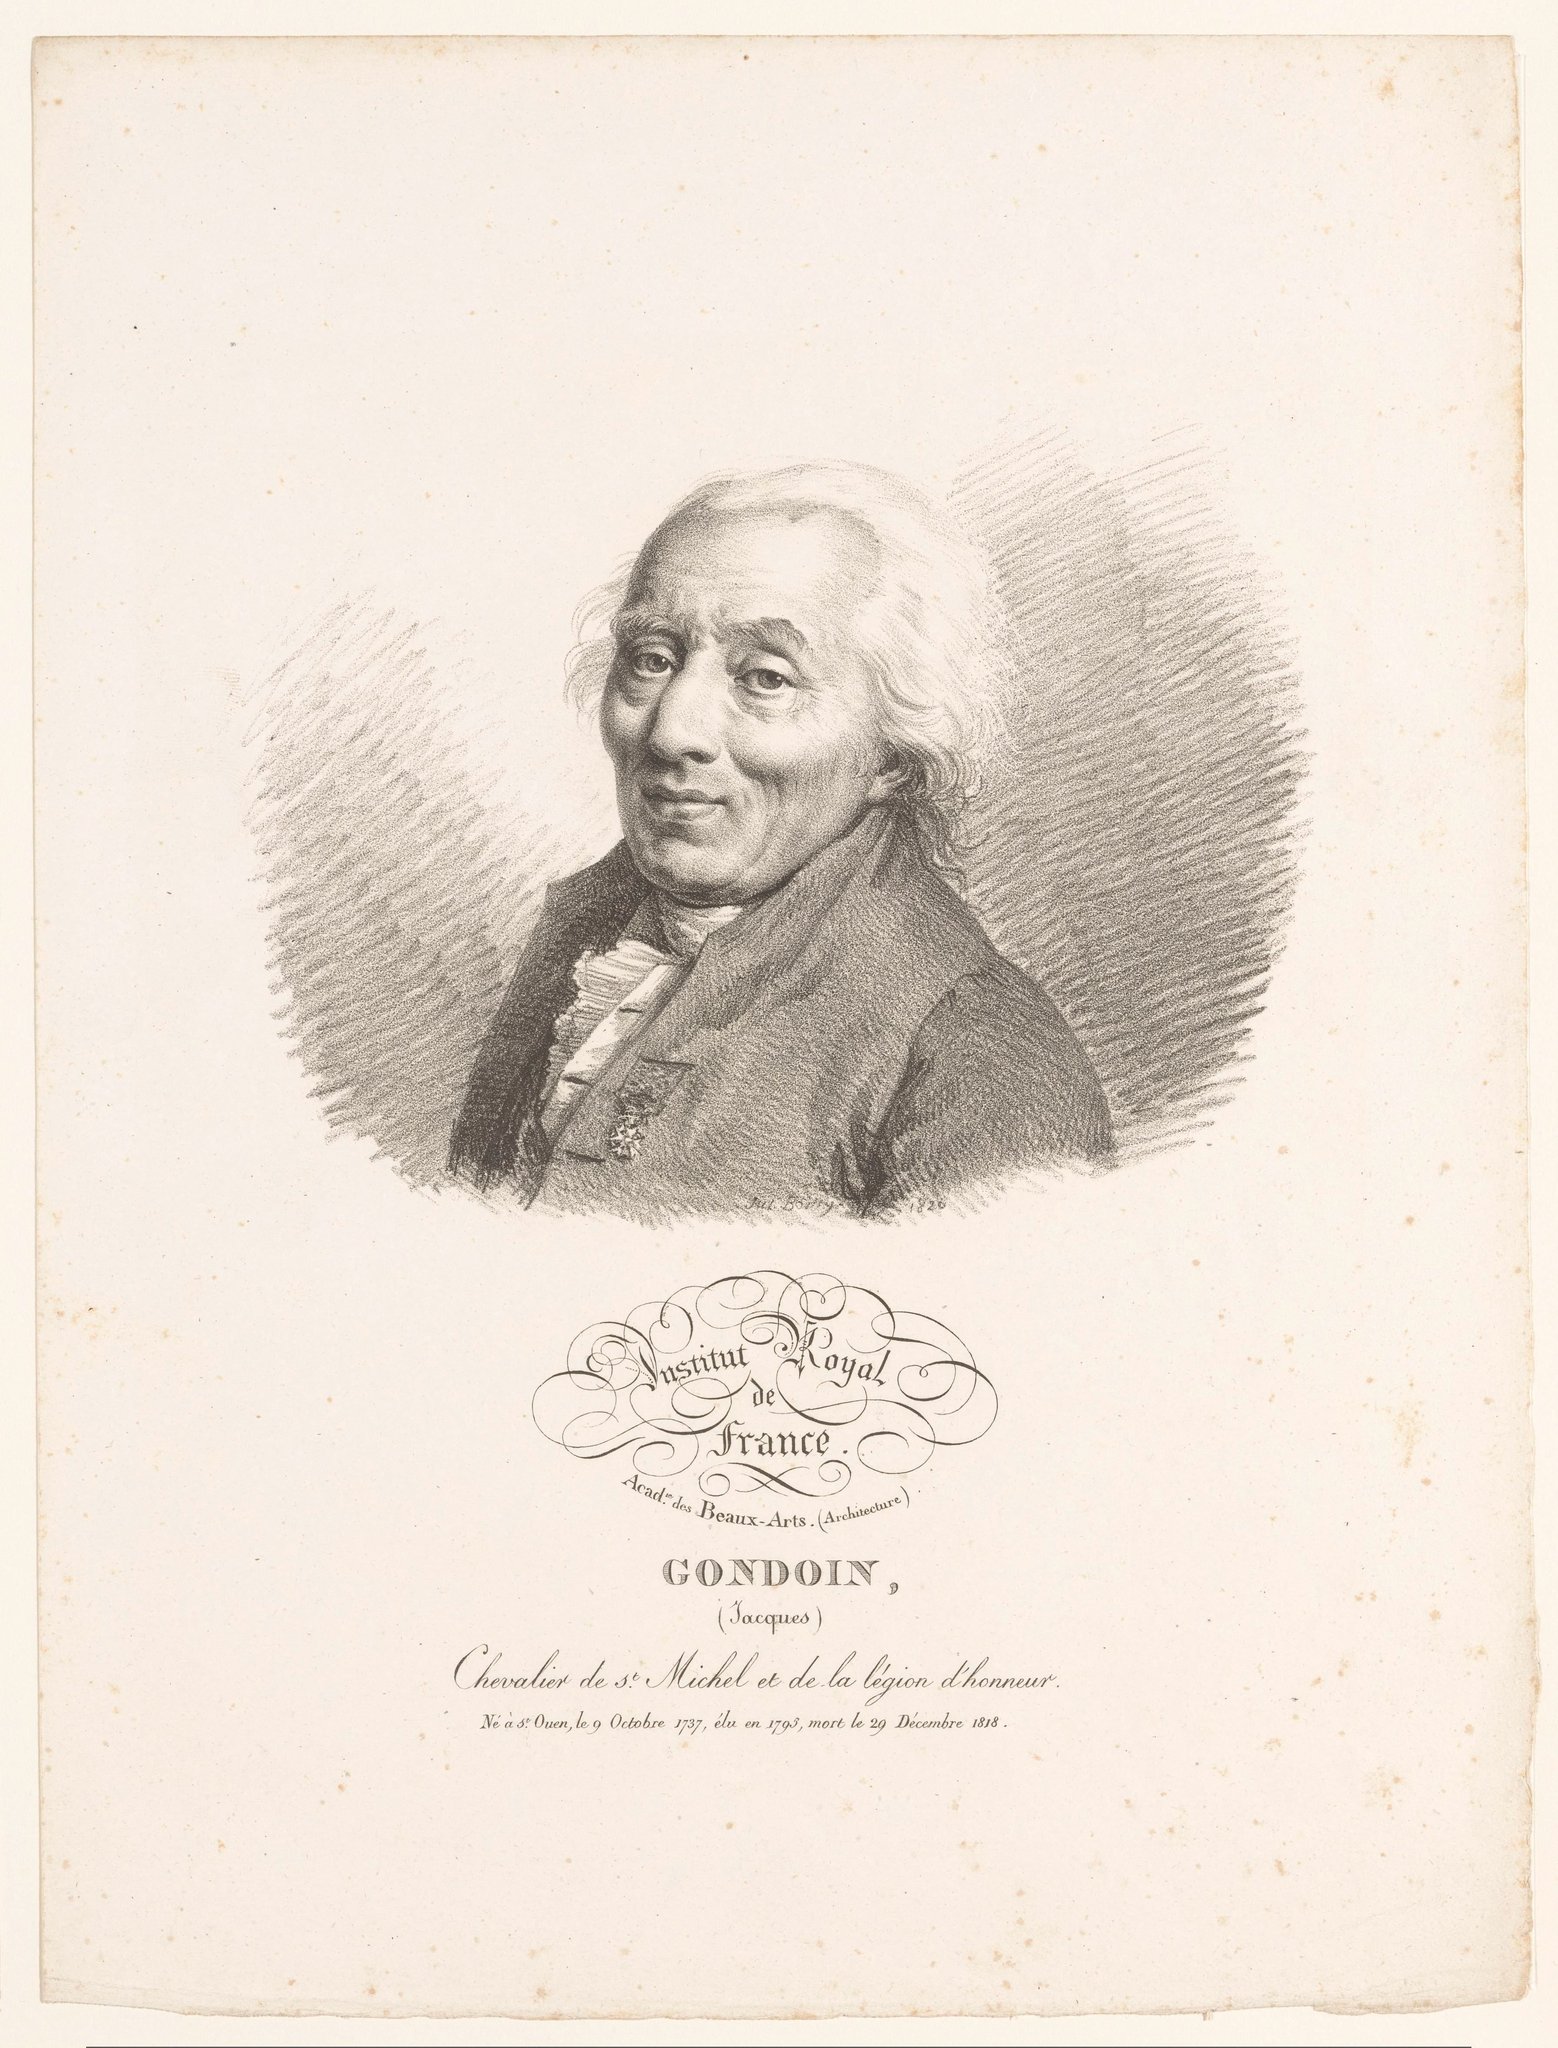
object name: print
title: Leden van het Institut Royal de France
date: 1820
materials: paper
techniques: lithograph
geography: paris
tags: paris, historical persons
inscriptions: collector's mark: Lugt 2228a